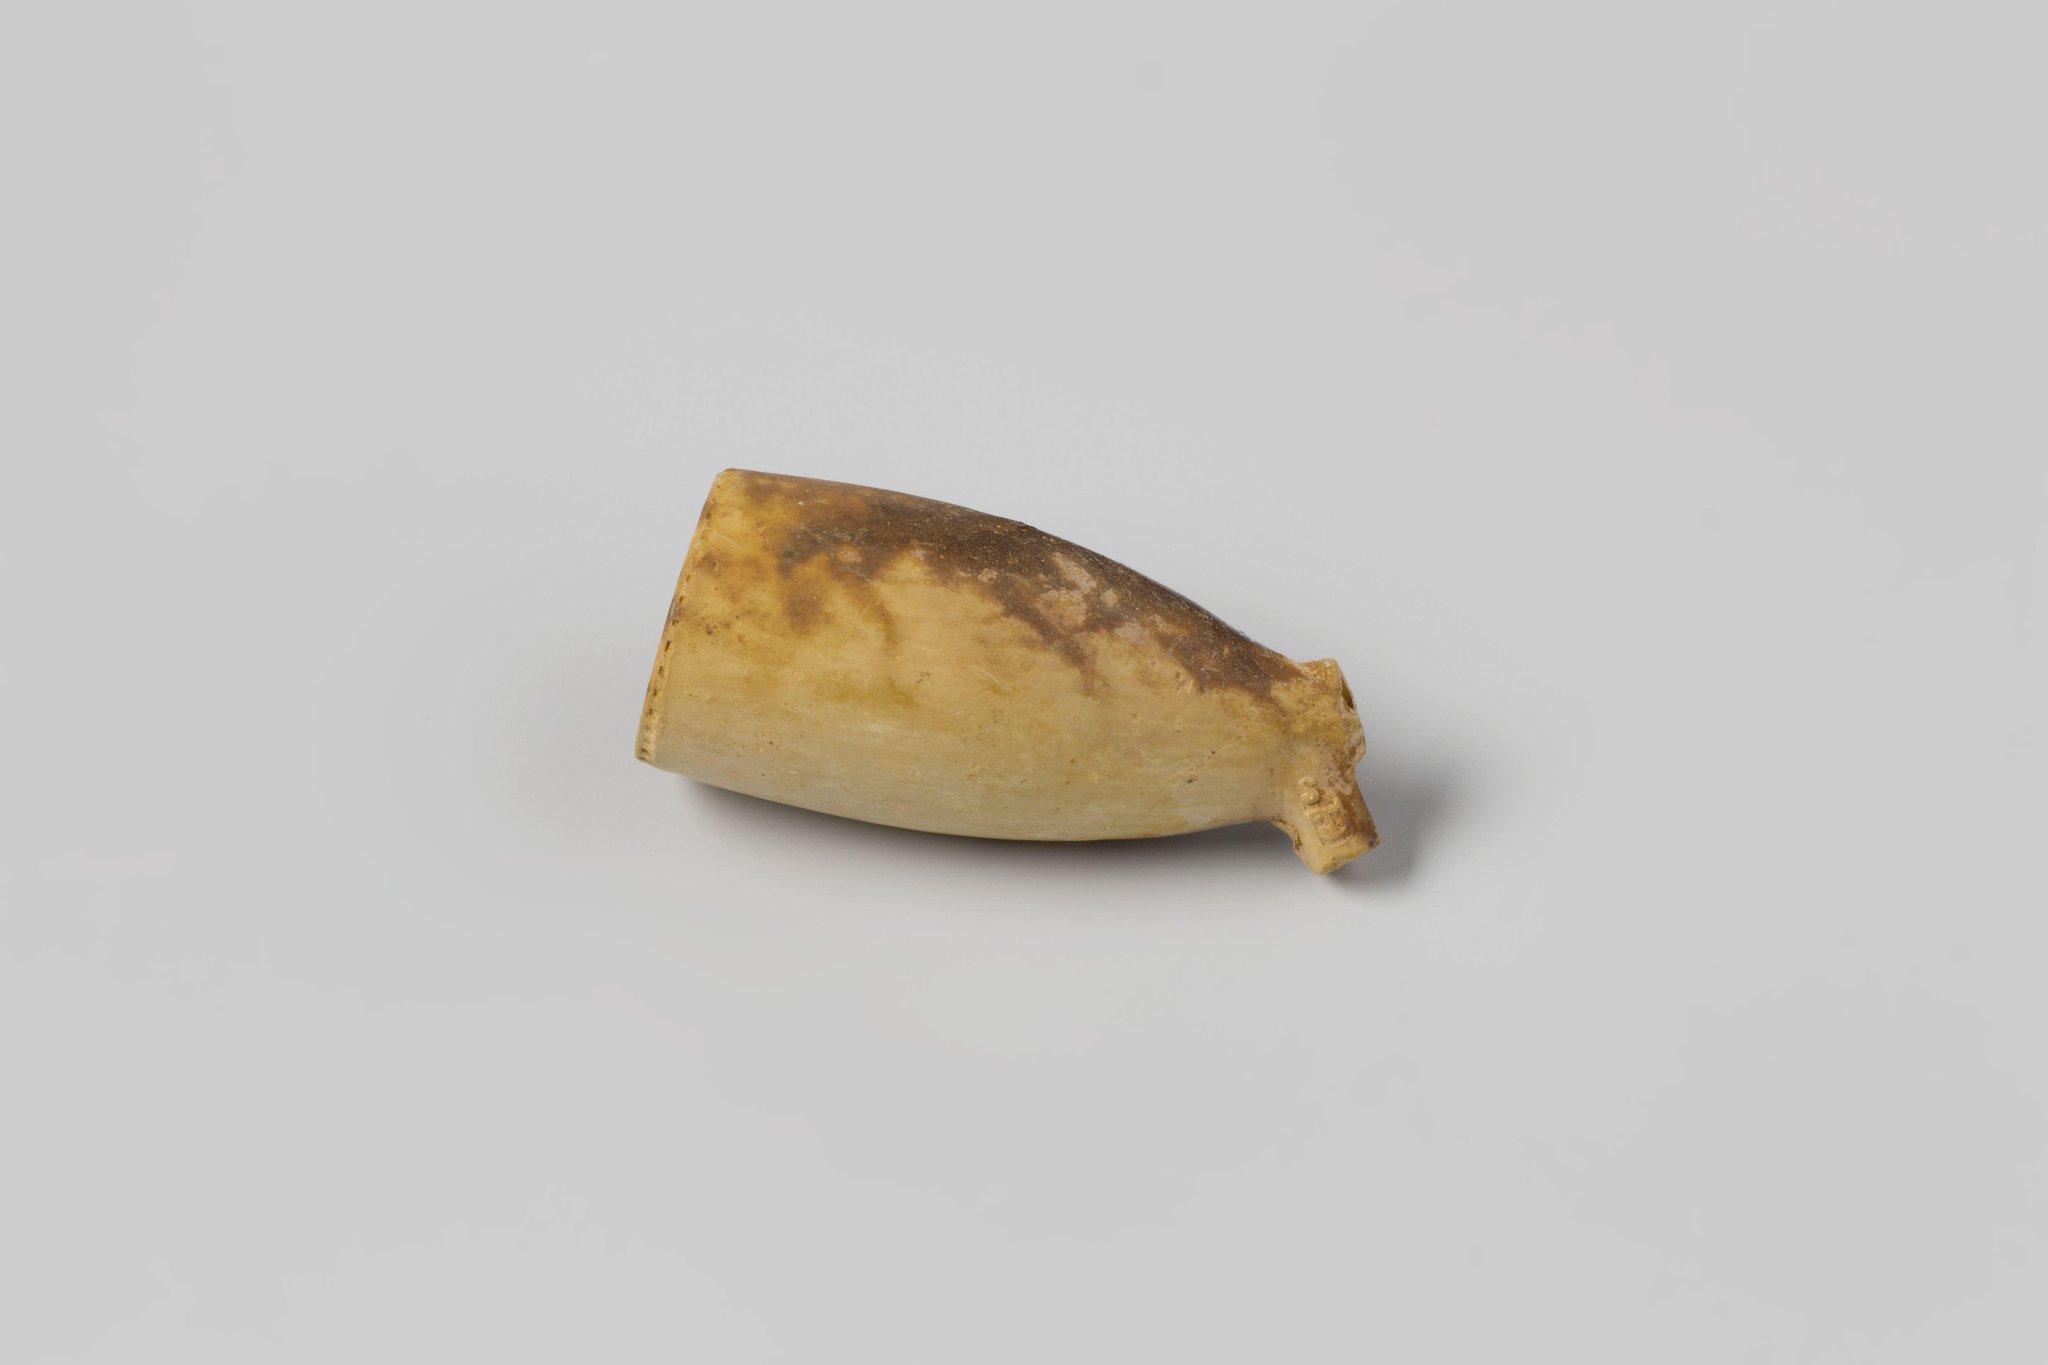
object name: pipe bowl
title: Pijpenkop uit het wrak van de Oost-Indiëvaarder Hollandia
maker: Anonymous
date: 1700-1743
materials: clay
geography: netherlands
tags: verenigde oostindische compagnie, hollandia (schip), annet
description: Pipe, bowl, heelmark: coat of arms of the city of Amsterdam; 1hsm2.